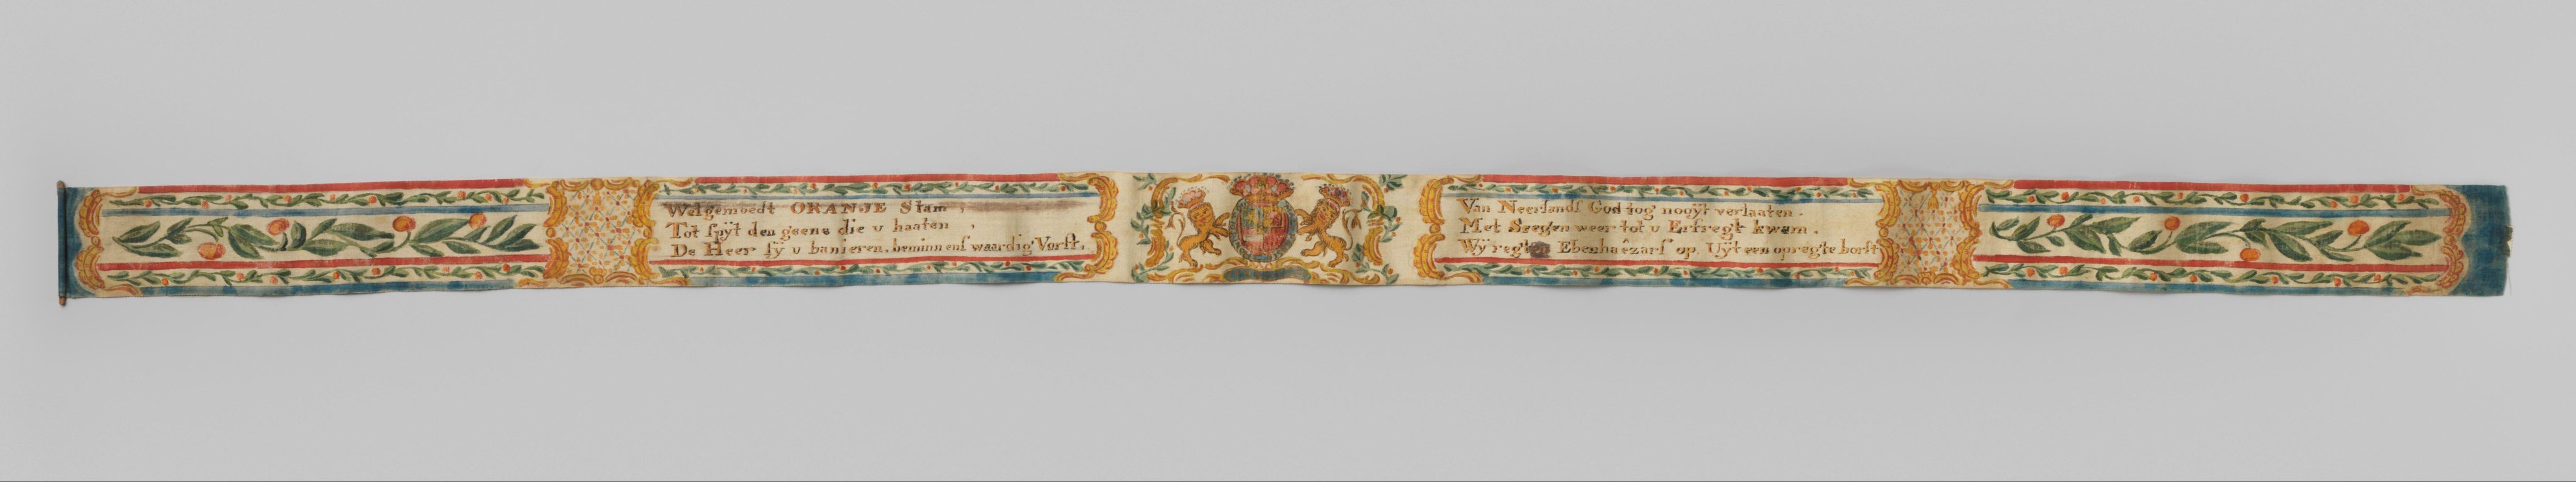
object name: ribbon material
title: Oranjelint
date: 1700-1800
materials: silk, wood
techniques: painted, sewing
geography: netherlands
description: Links is het lint rond een klein stokje gedraaid. V.l.n.r.: bloemmotieven met rood-wit-blauwe banen, het eerste deel van het opschrift. het wapenschild van Oranje gedragen door twee gekroonde leeuwen, het tweede deel van het opschrift gevolgd door bloemmotieven met rood-wit-blauwe banen. In de bloemmotieven zin Oranje-appelen verwerkt. Opschrift: l.: Welgemoedt ORANJE Stam, Tot spyt den geens die u haaten, De Heer sy u banieren, beminnenswaardig Vorst. R.: Van Neerlands God tog nooyt verlaten.........etc